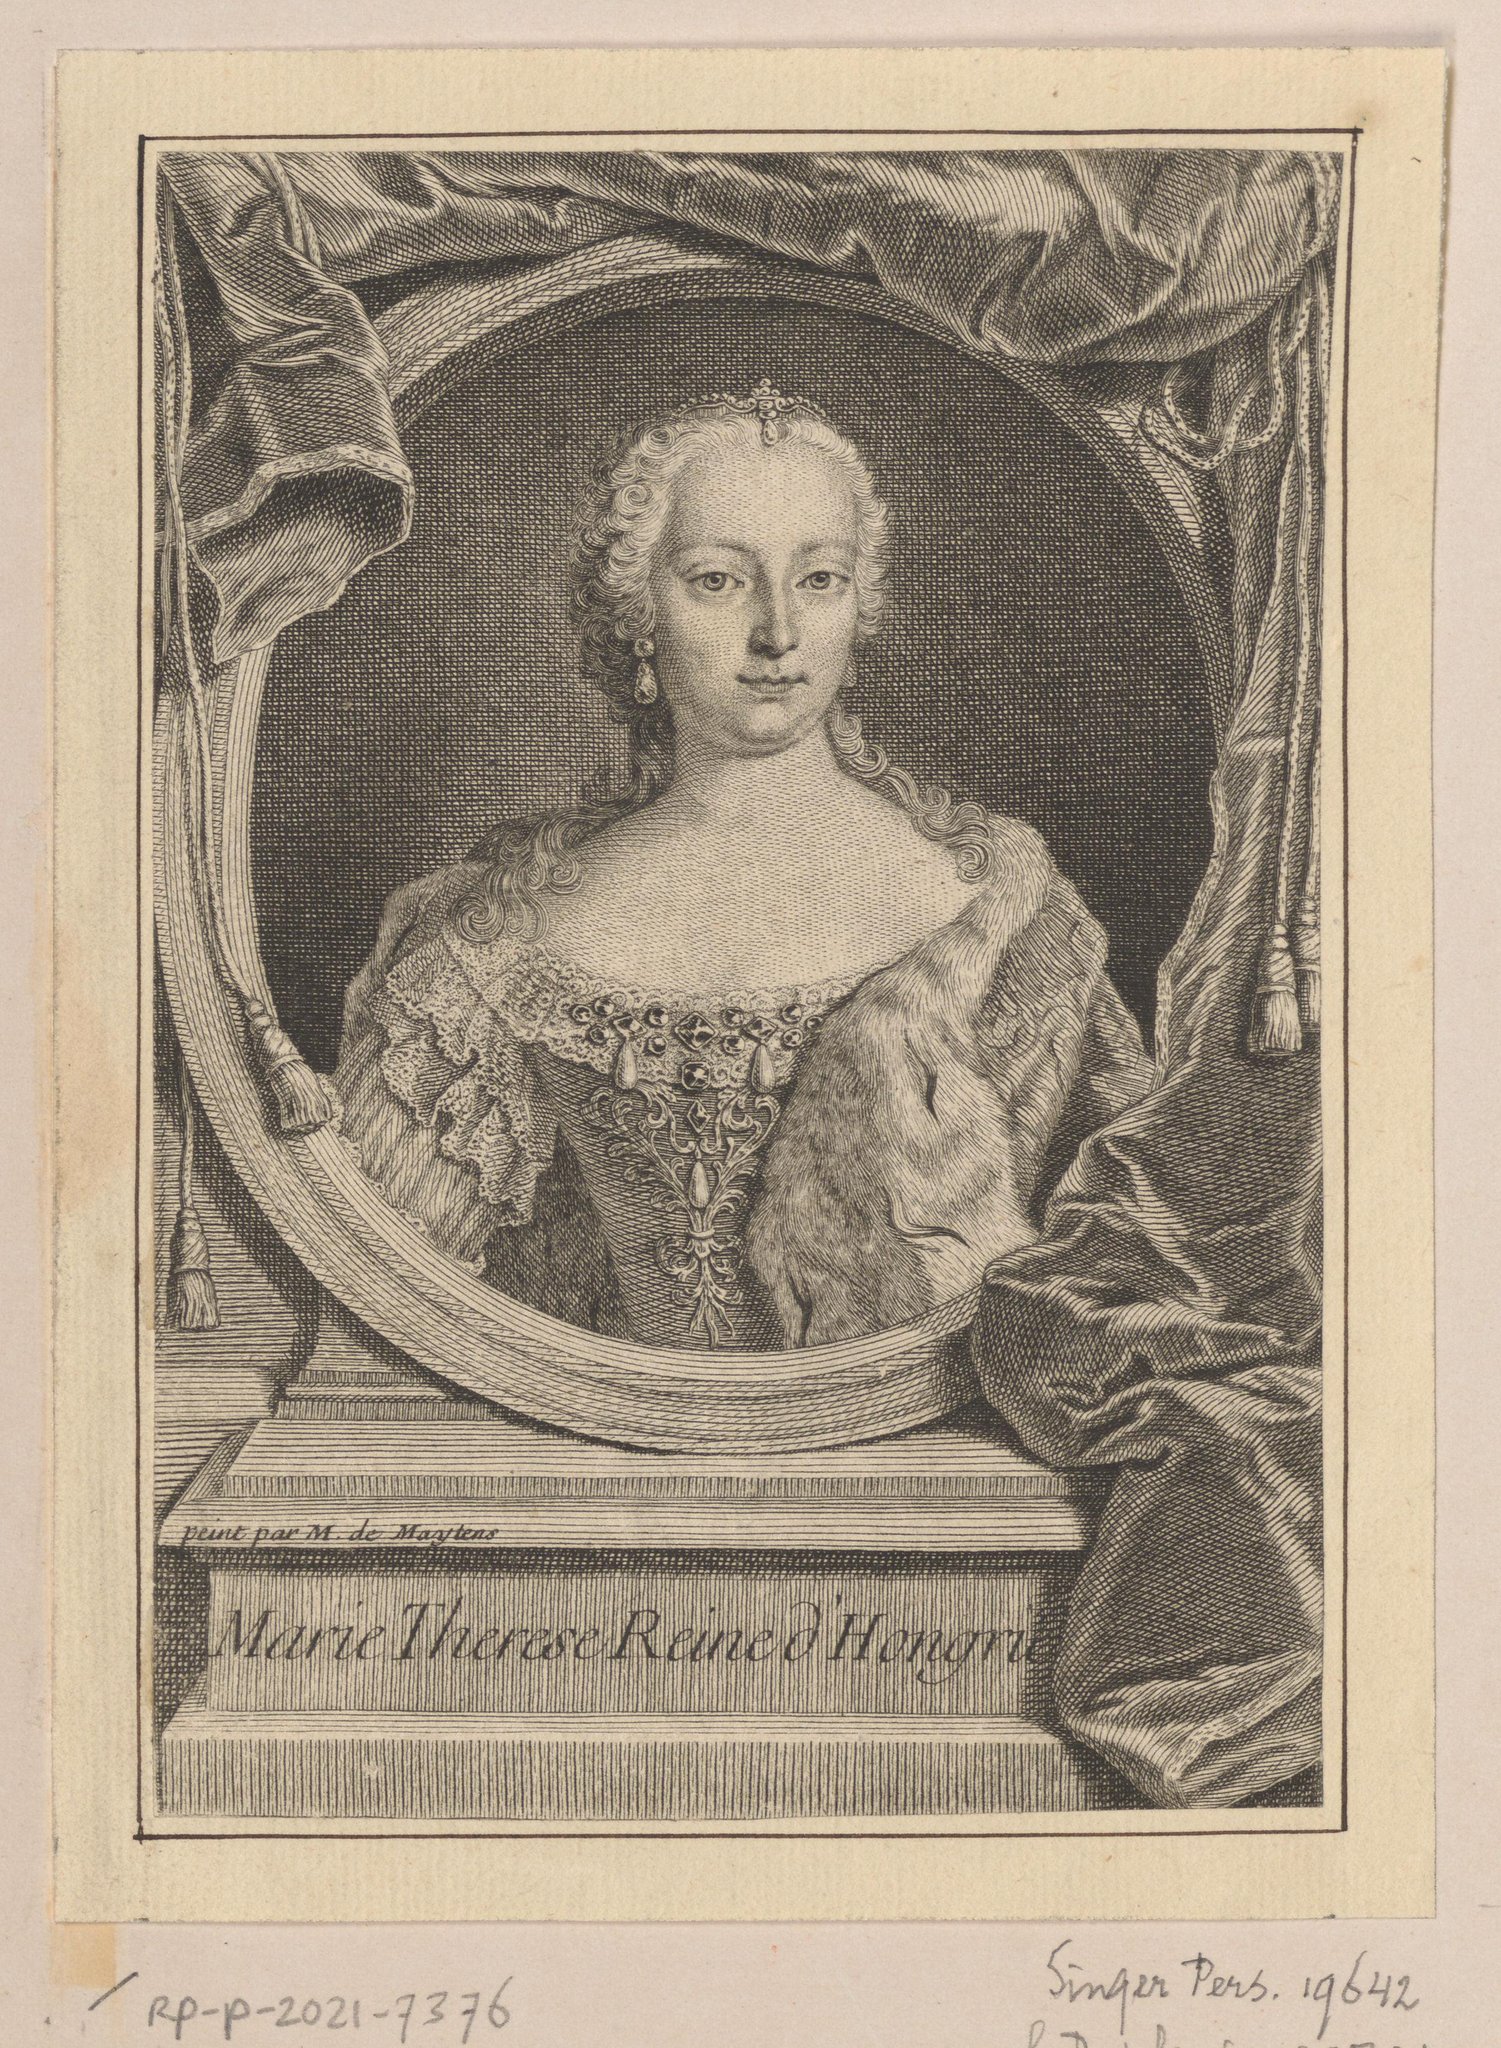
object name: print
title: Portret van Maria Theresia van Oostenrijk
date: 1740-1780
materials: paper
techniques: engraving, snipping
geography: france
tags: vienna, maria theresia (rooms-duits keizerin), historical persons - bb - woman, (feigned) picture curtain, ornament ~ medallion, emperor - bb - female ruler